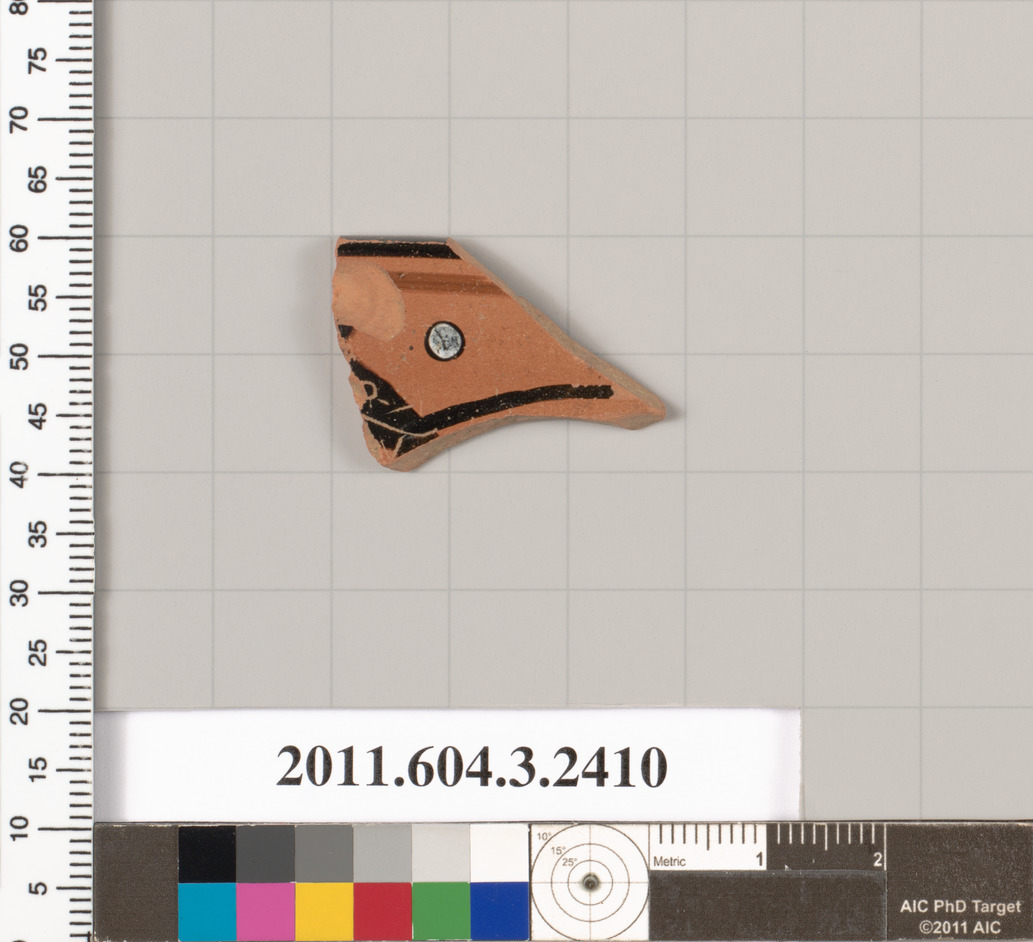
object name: kylix fragment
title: Terracotta rim fragment of a kylix: eye-cup (drinking cup)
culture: greek, attic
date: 530-510 BCE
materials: terracotta